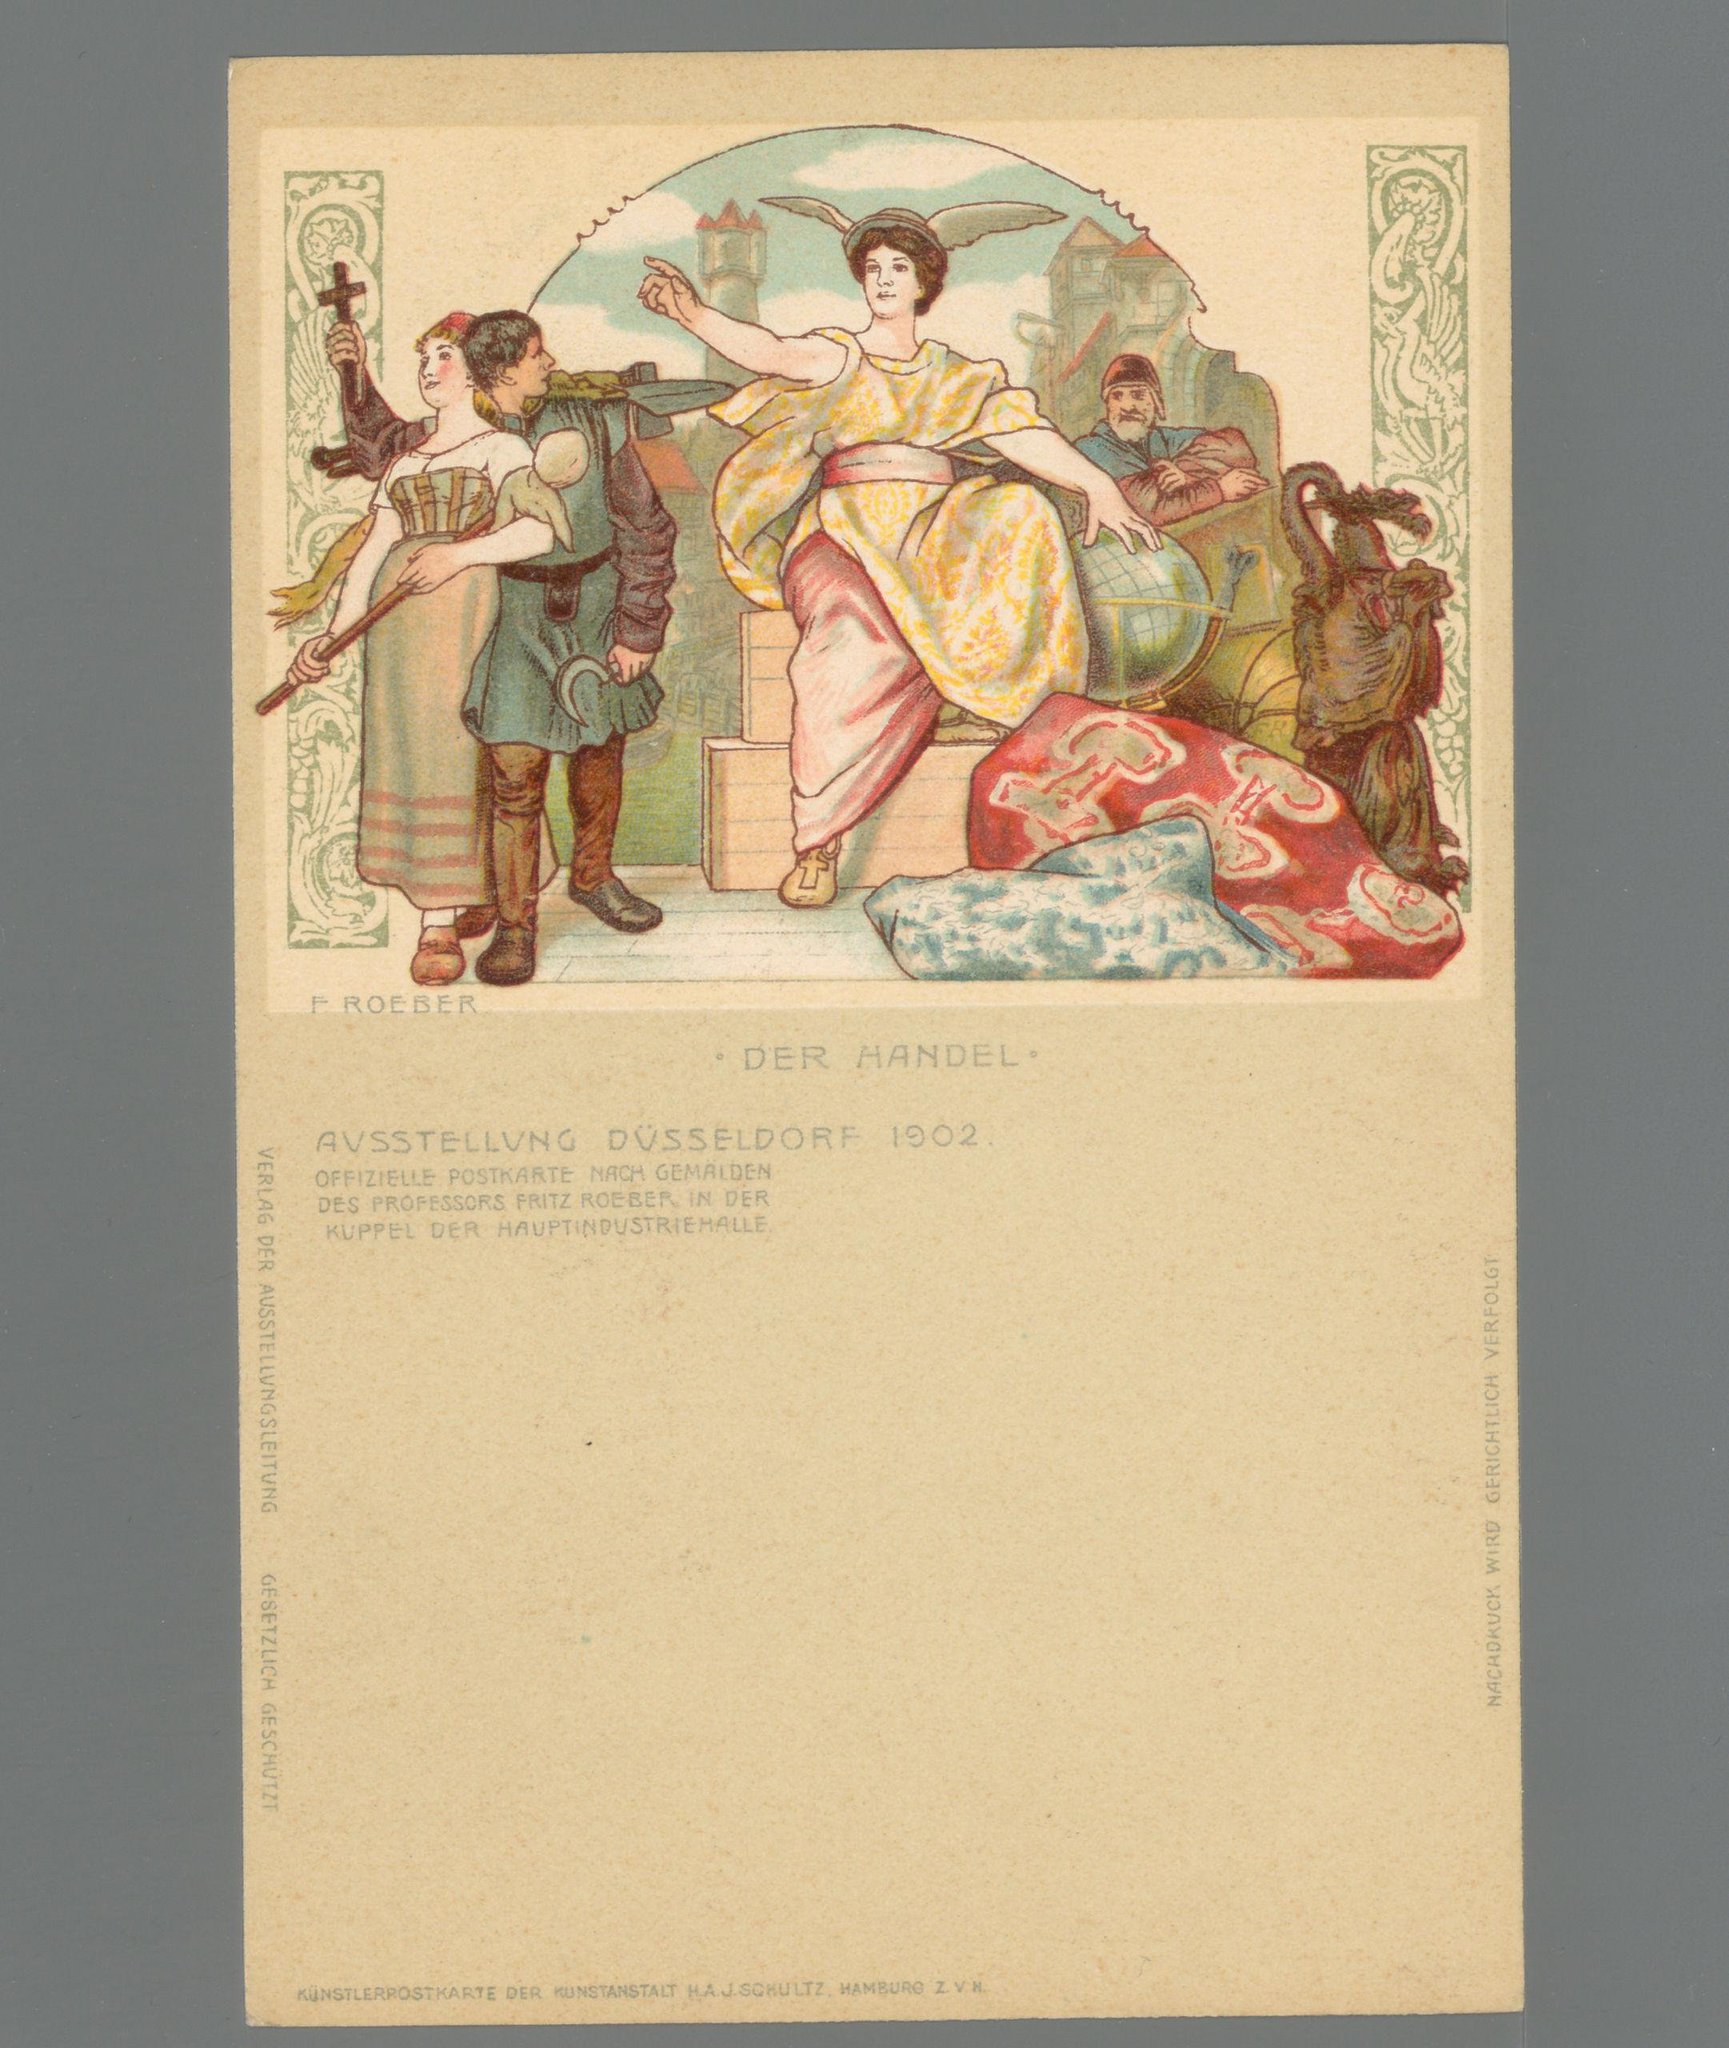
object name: ansichtkaart, prentbriefkaart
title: Der Handel. Ausstellung Düsseldorf 1902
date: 1902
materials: cardboard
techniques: lithograph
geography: hamburg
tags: trade, commerce and finance, temporary exhibition, 'salon'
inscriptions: date